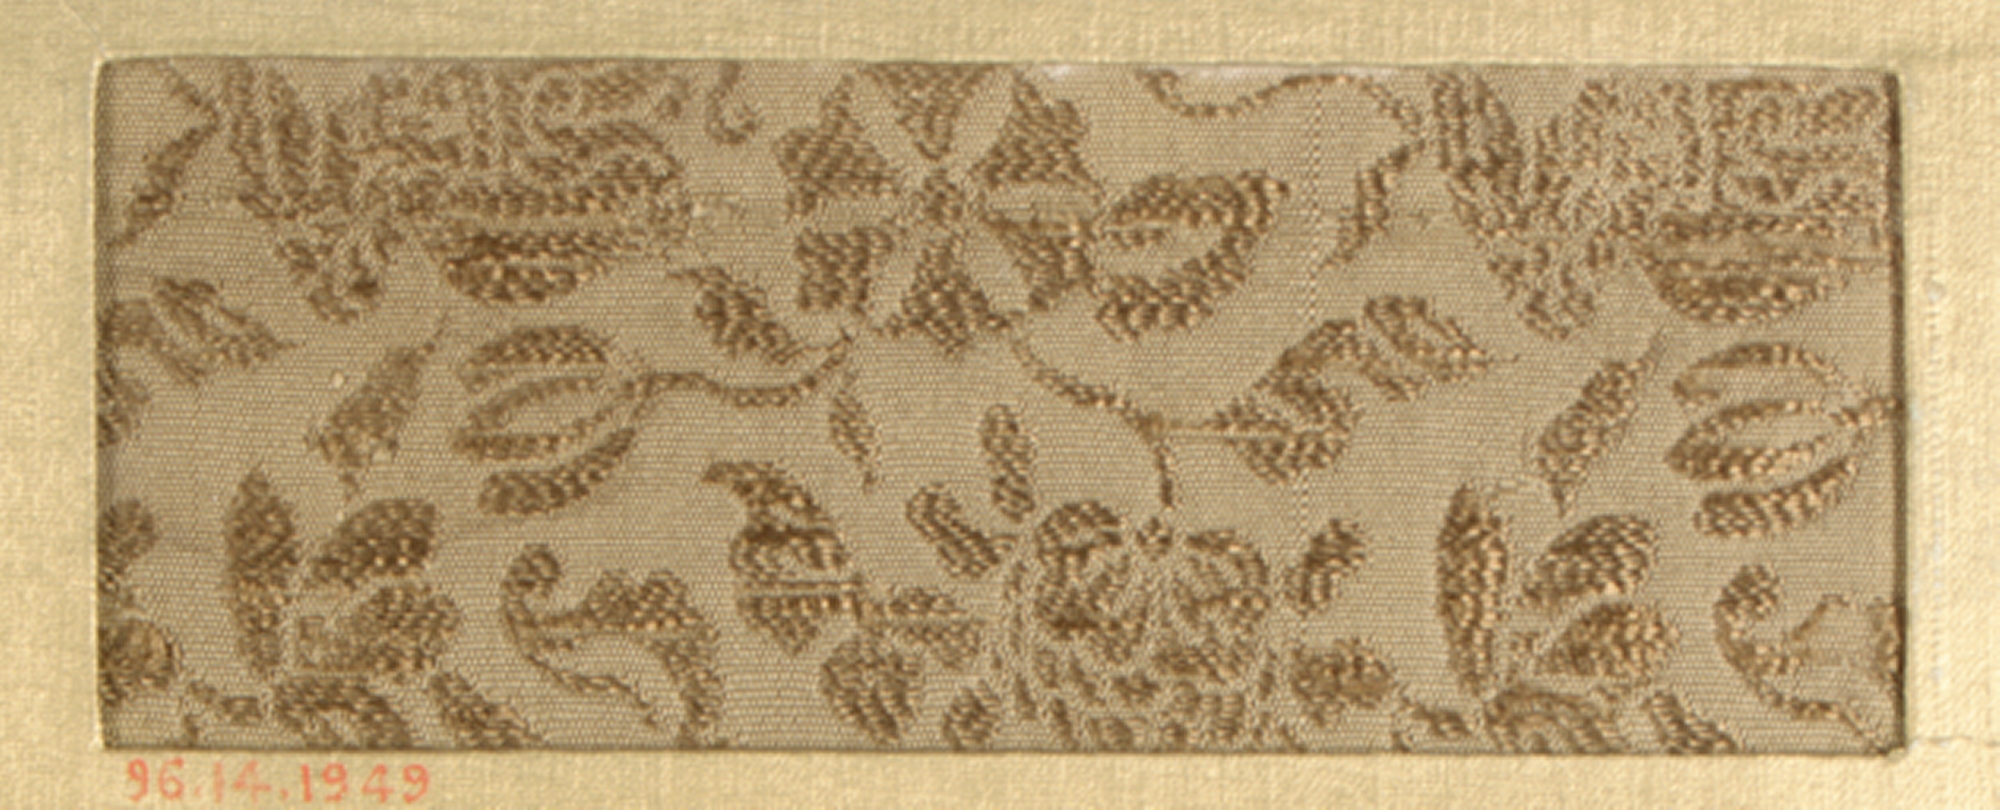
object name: piece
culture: japanese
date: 1701-1900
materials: silk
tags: leaves